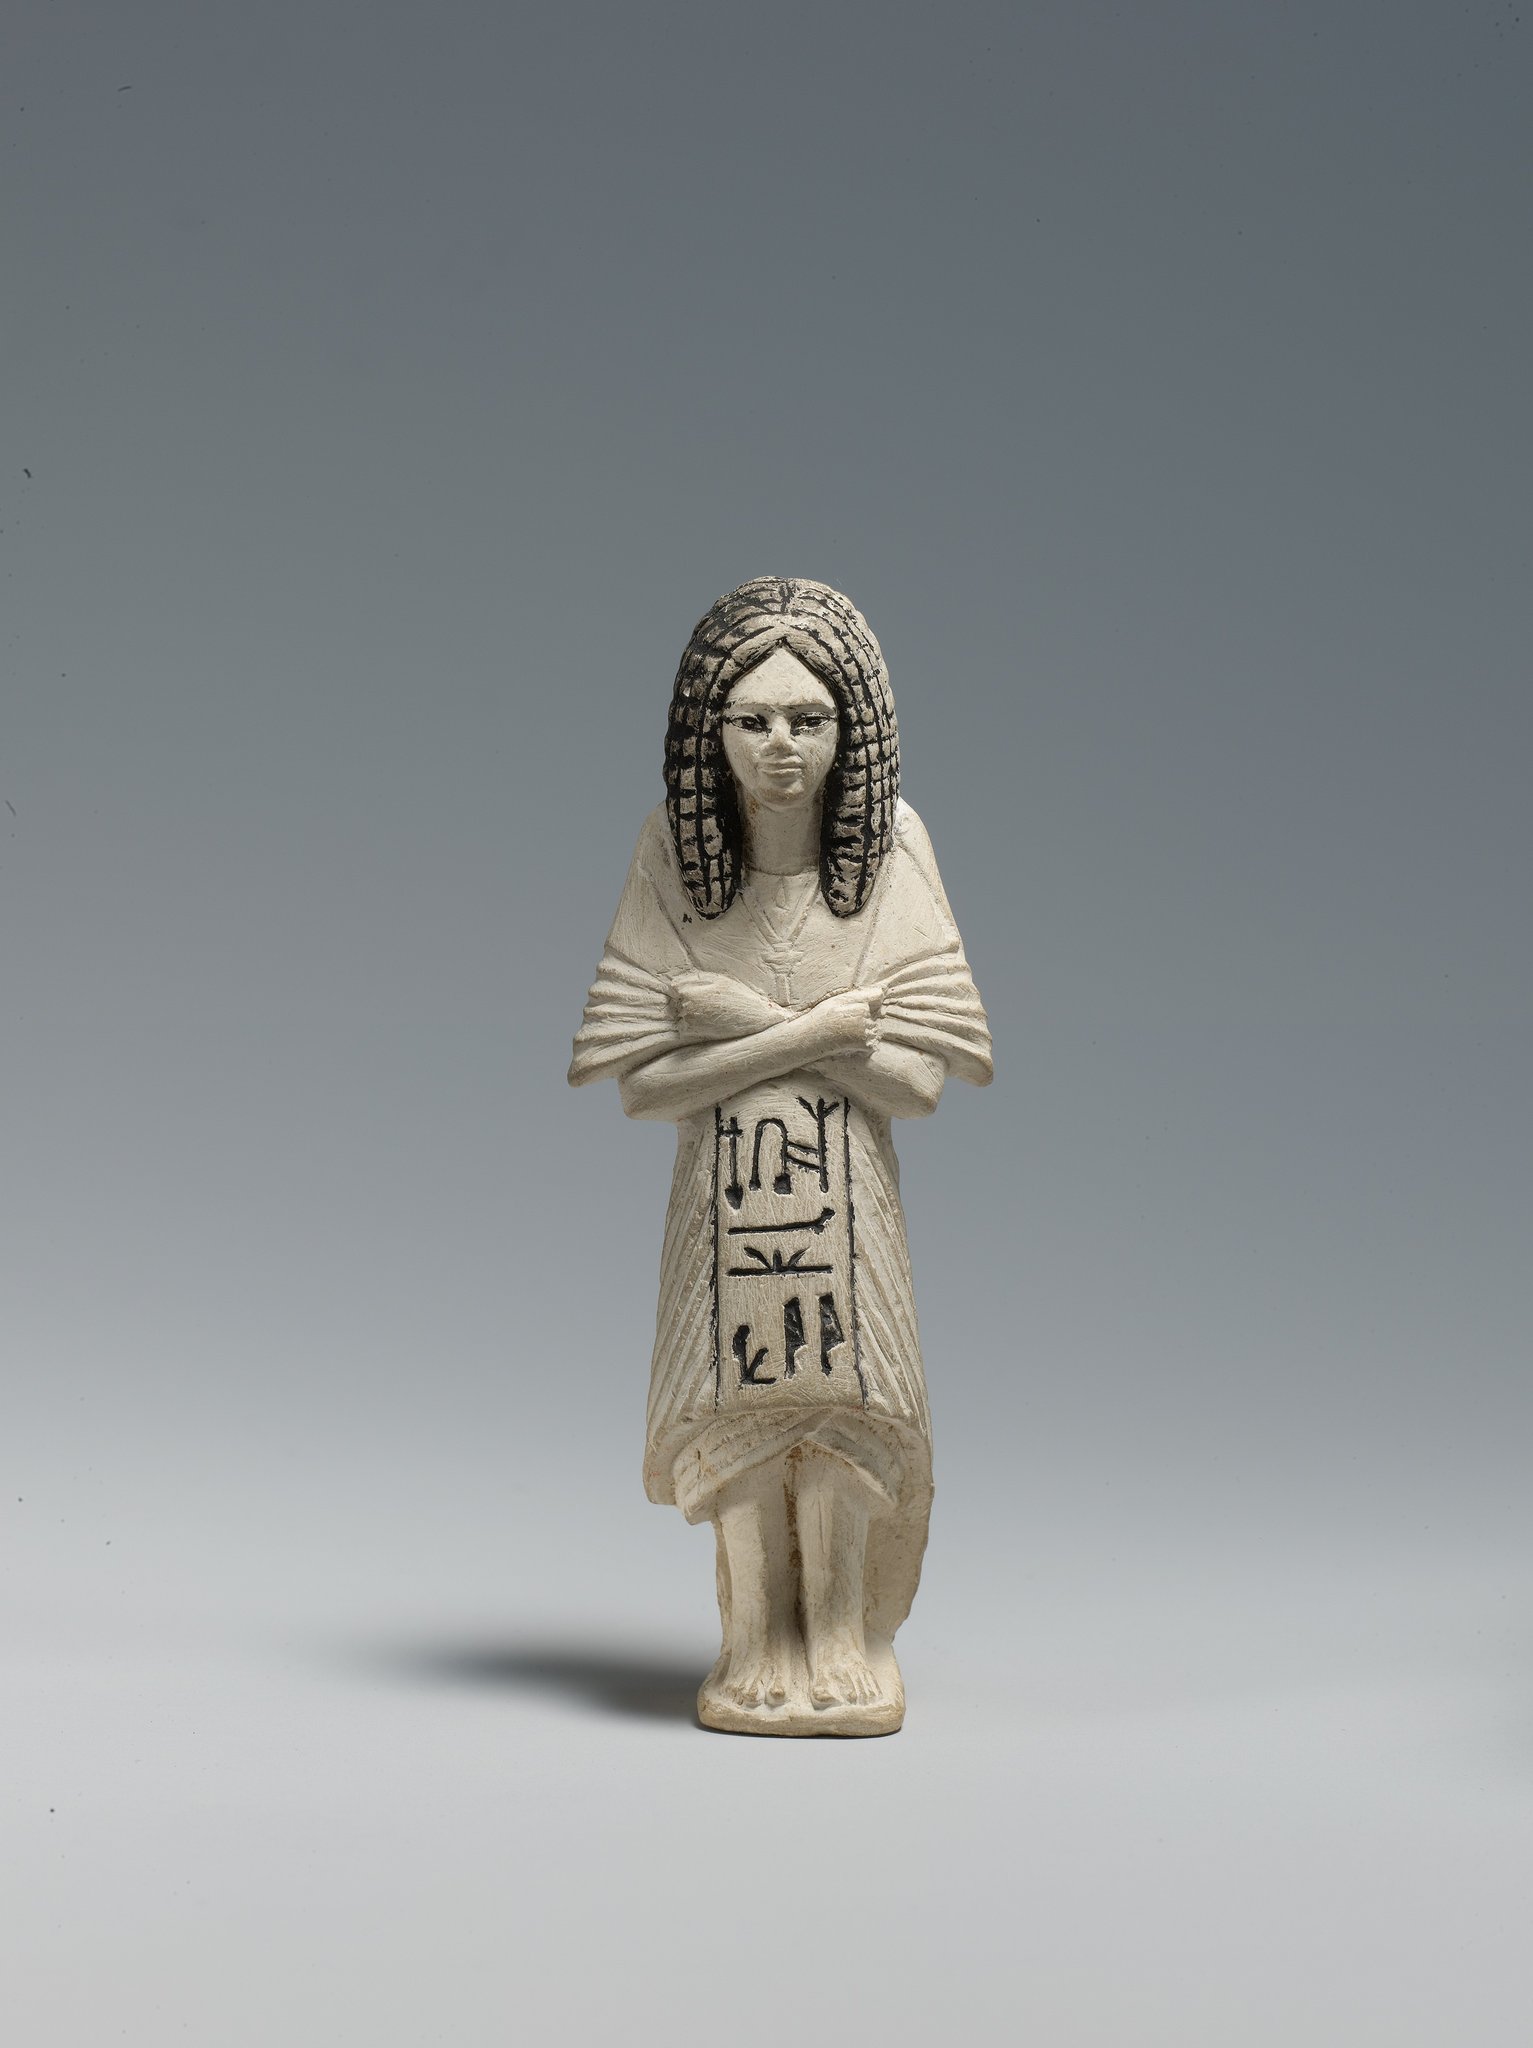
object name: shabti, huy, scribe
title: Shabti of the Scribe Huy wearing a Bat-pendant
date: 1295-1185 BCE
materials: limestone, pigment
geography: egypt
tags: hieroglyphs